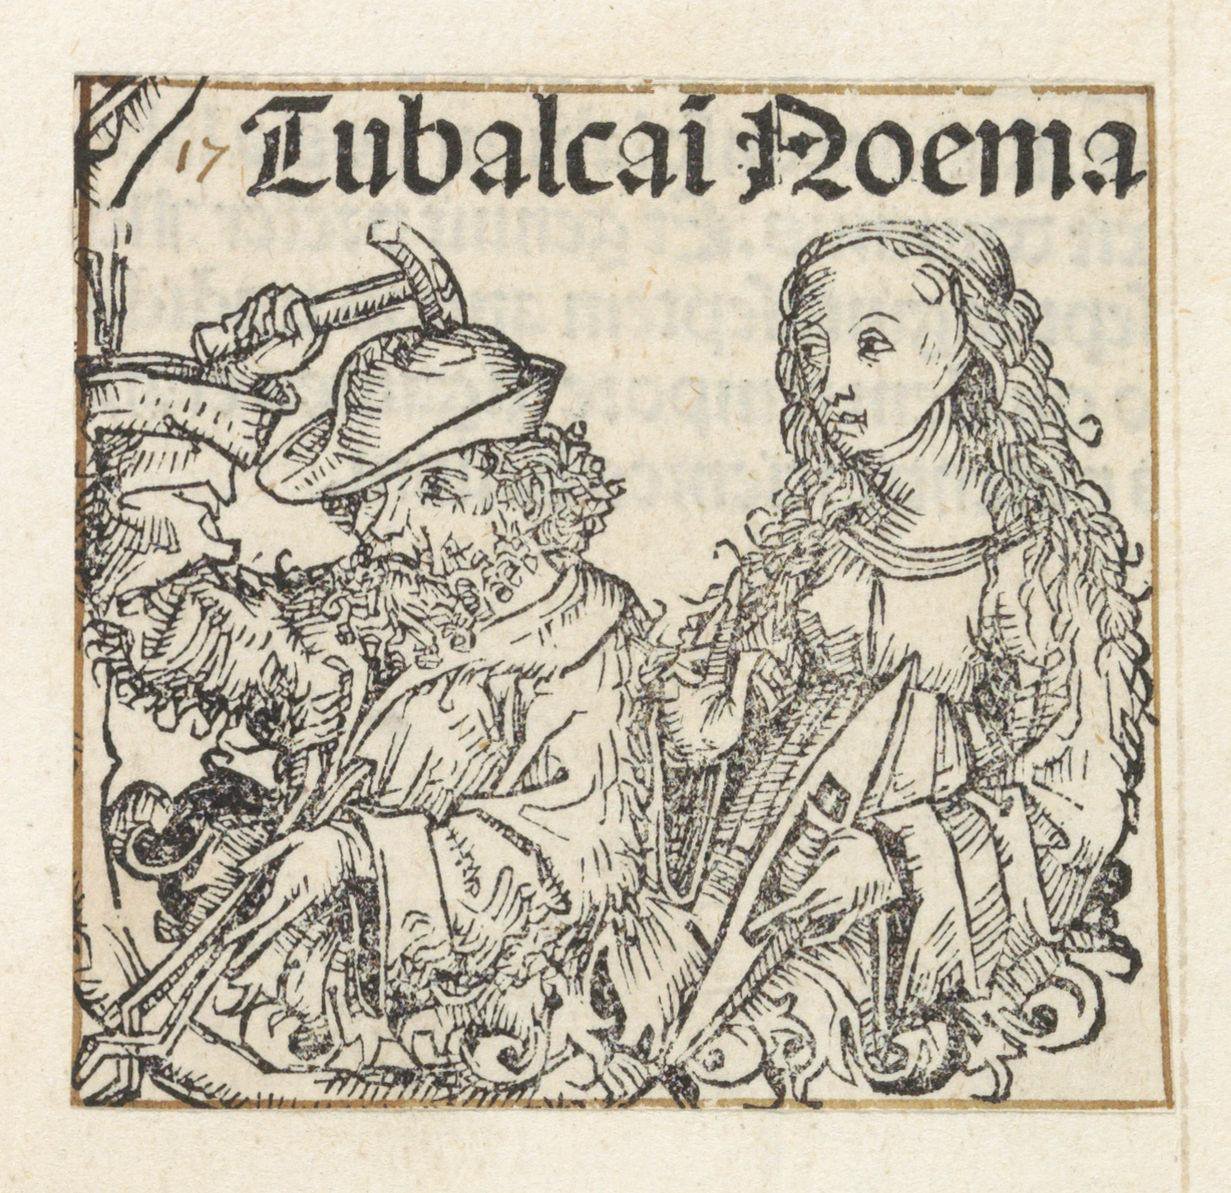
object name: album leaf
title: Tubalcai / Noema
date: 1493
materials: paper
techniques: letterpress printing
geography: nuremberg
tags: persons from the old testament (not in biblical context, nor occurring in legendary/historical extensions included in division 71)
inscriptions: inscription: ‘17’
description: Een bloemkelk met een man en vrouw. De vrouw heeft een weefspoel in haar handen. De man een tang en een hamer. De voorstelling is een fragment van de stamboom van Christus in de Liber Chronicarum. De tekst identificeert de personen als de smid Tubal-Kaïn en zijn zuster Naäma. De prent maakt deel uit van een album.